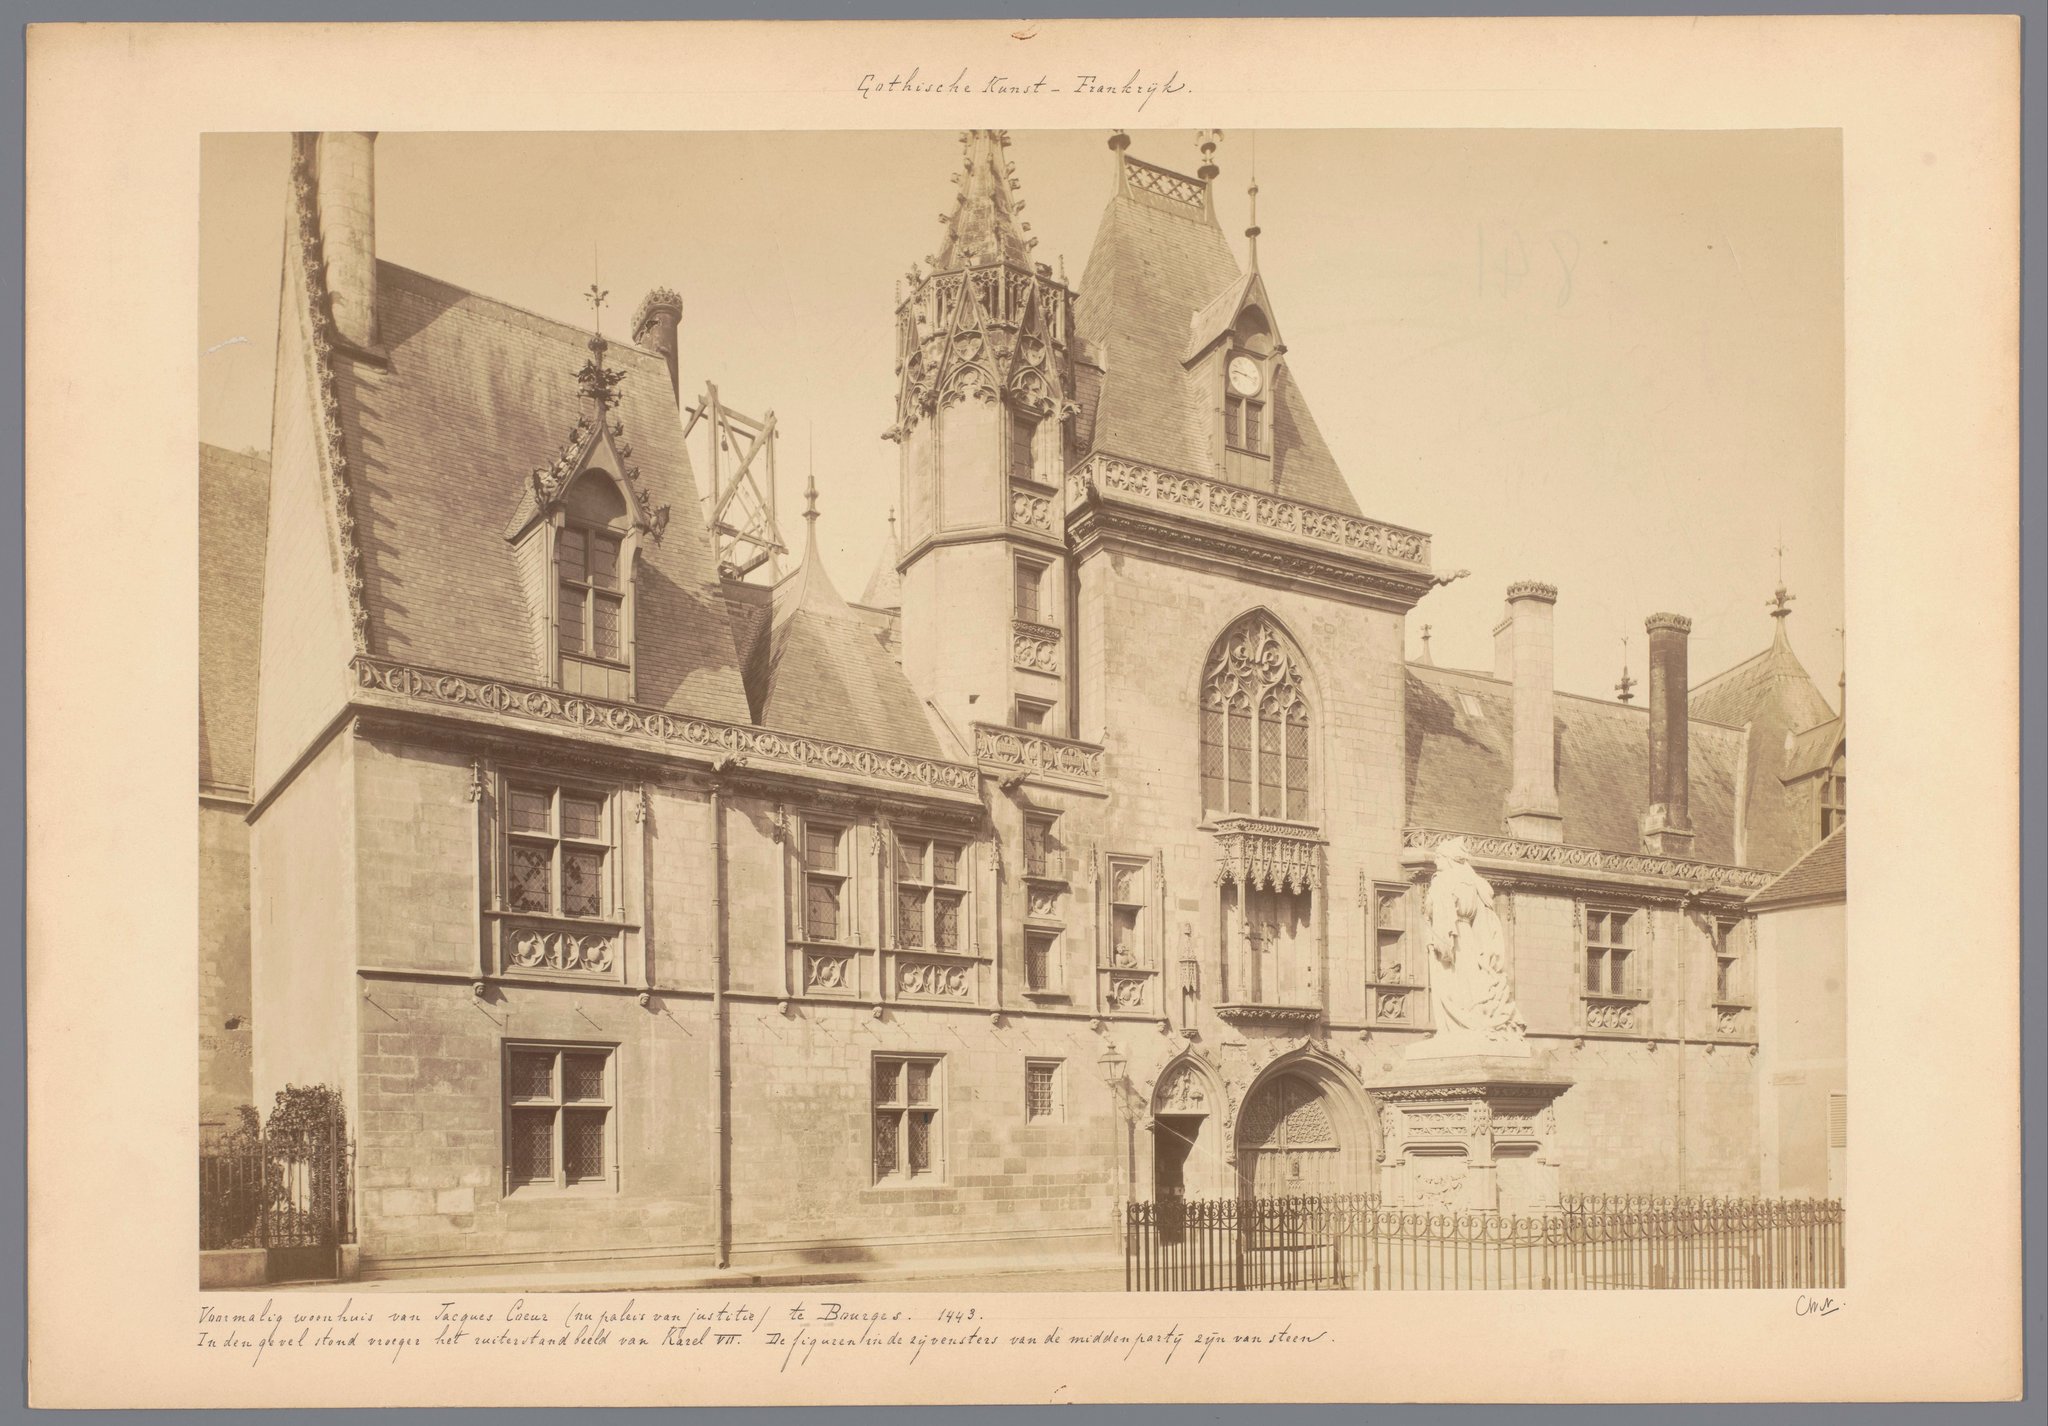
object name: photograph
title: Voorgevel van het Palais Jacques-Cœur te Bourges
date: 1875-1900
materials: cardboard, photographic support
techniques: albumen print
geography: paris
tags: monument, statue, hôtel, i.e. small palace in city, façade (of house or building)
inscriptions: collector's mark: ‘KUNSTNIJVERHEIDSCHOOL QUELLINUS AMSTERDAM FRANS HALSSTRAAT 14.’, inscription: ‘CWN.’, collector's mark: ‘INSTITUUT VOOR KUNST- NIJVERHEIDSONDERWIJS GABRIËL METSUSTRAAT No. 16. AMSTERDAM’, inscription: ‘Gothische Kunst - Frankrijk. Voormalig woonhuis van Jacques Coeur (...) De figuren in de zijvensters van de middenpartij zijn van steen.’, name: ‘J. KUHN, Editeur, 220, Rue de Rivoli. PARIS’